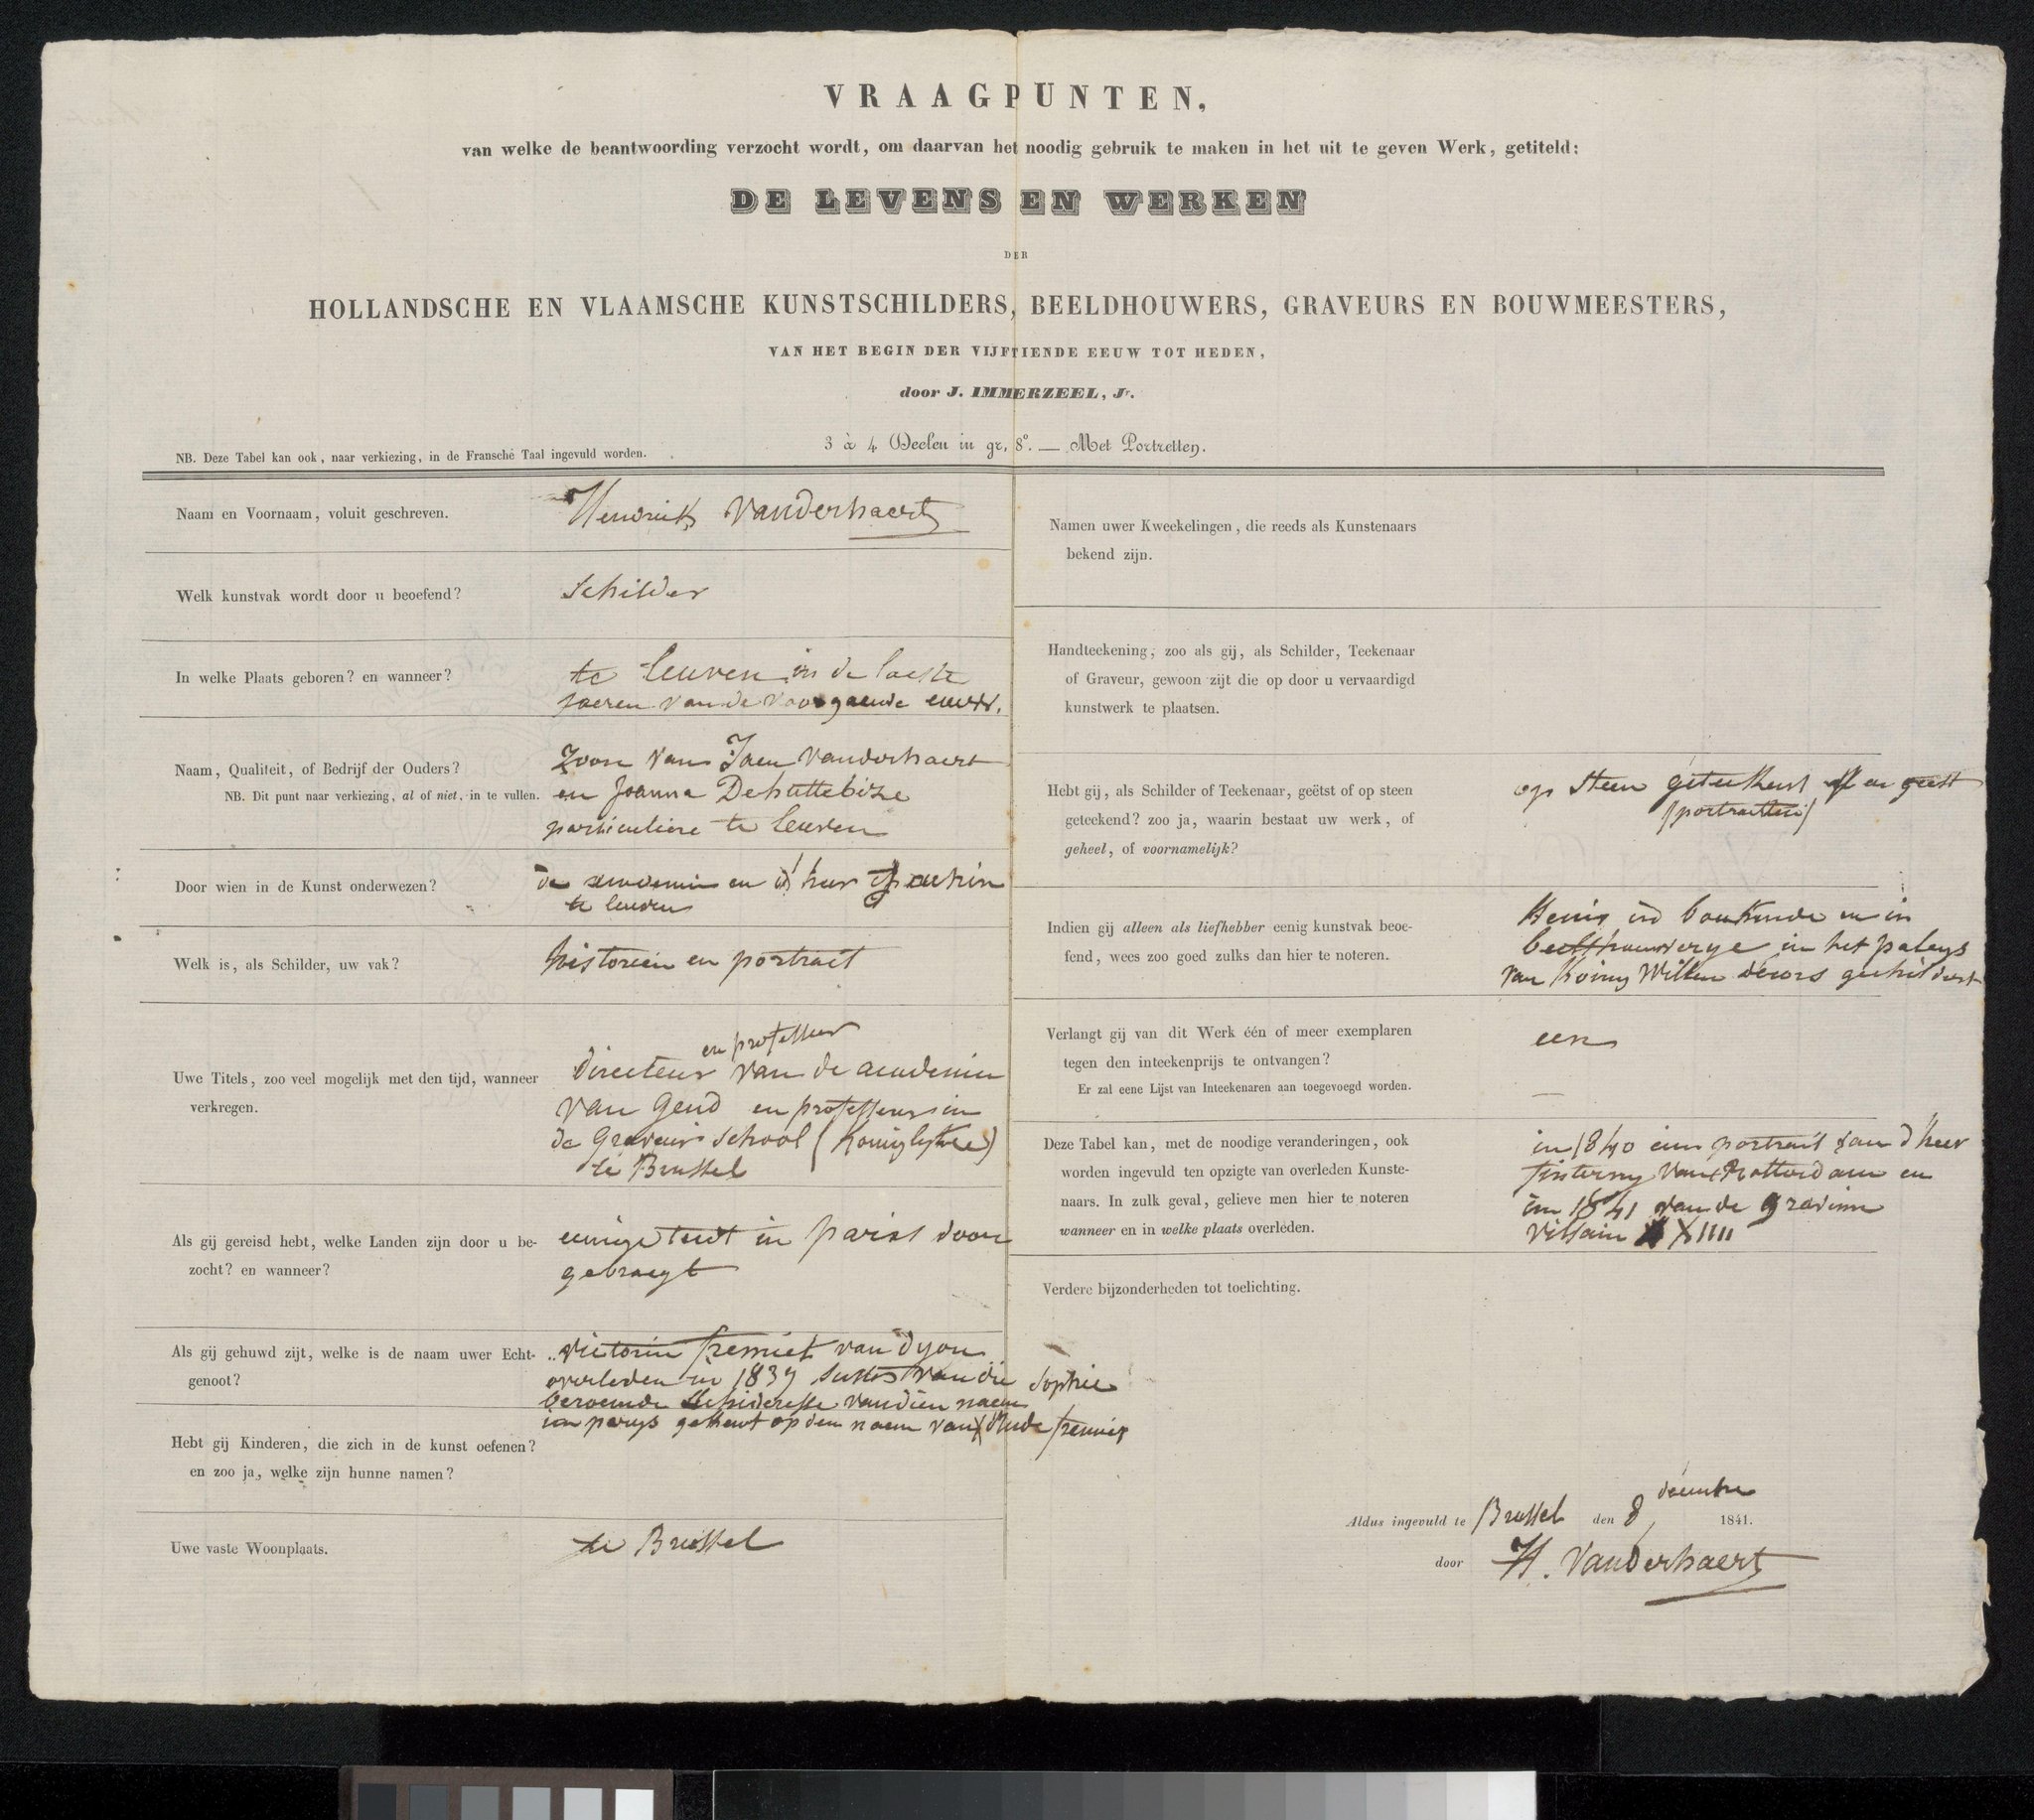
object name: questionnaire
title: Enquêteformulier ingevuld door Henri van der Haert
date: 1841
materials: ink, paper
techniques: pen, printing, writing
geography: brussels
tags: louvain, ghent, print maker, draughtsman, henri van der haert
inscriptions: watermark, inscription: ‘Vraagpunten,/ van welke de beantwoording verzocht wordt, om daarvan het noodig gebruik te maken in het uit te geven Werk, getiteld: De levens en werken/ der Hollandsche en Vlaamsche kunstschilders, beeldhouwers,/ graveurs en bouwmeesters, van het begin der vijftiende eeuw tot heden/ door J. Immerzeel, Jr.’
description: Opgenomen in: Immerzeel, J. Jr., De levens en werken der Hollandsche en Vlaamsche kunstschilders, beeldhouwers, graveurs en bouwmeesters, van het begin der vijftiende eeuw tot heden, Amsterdam: J.C. van Kesteren, 1842-1843.